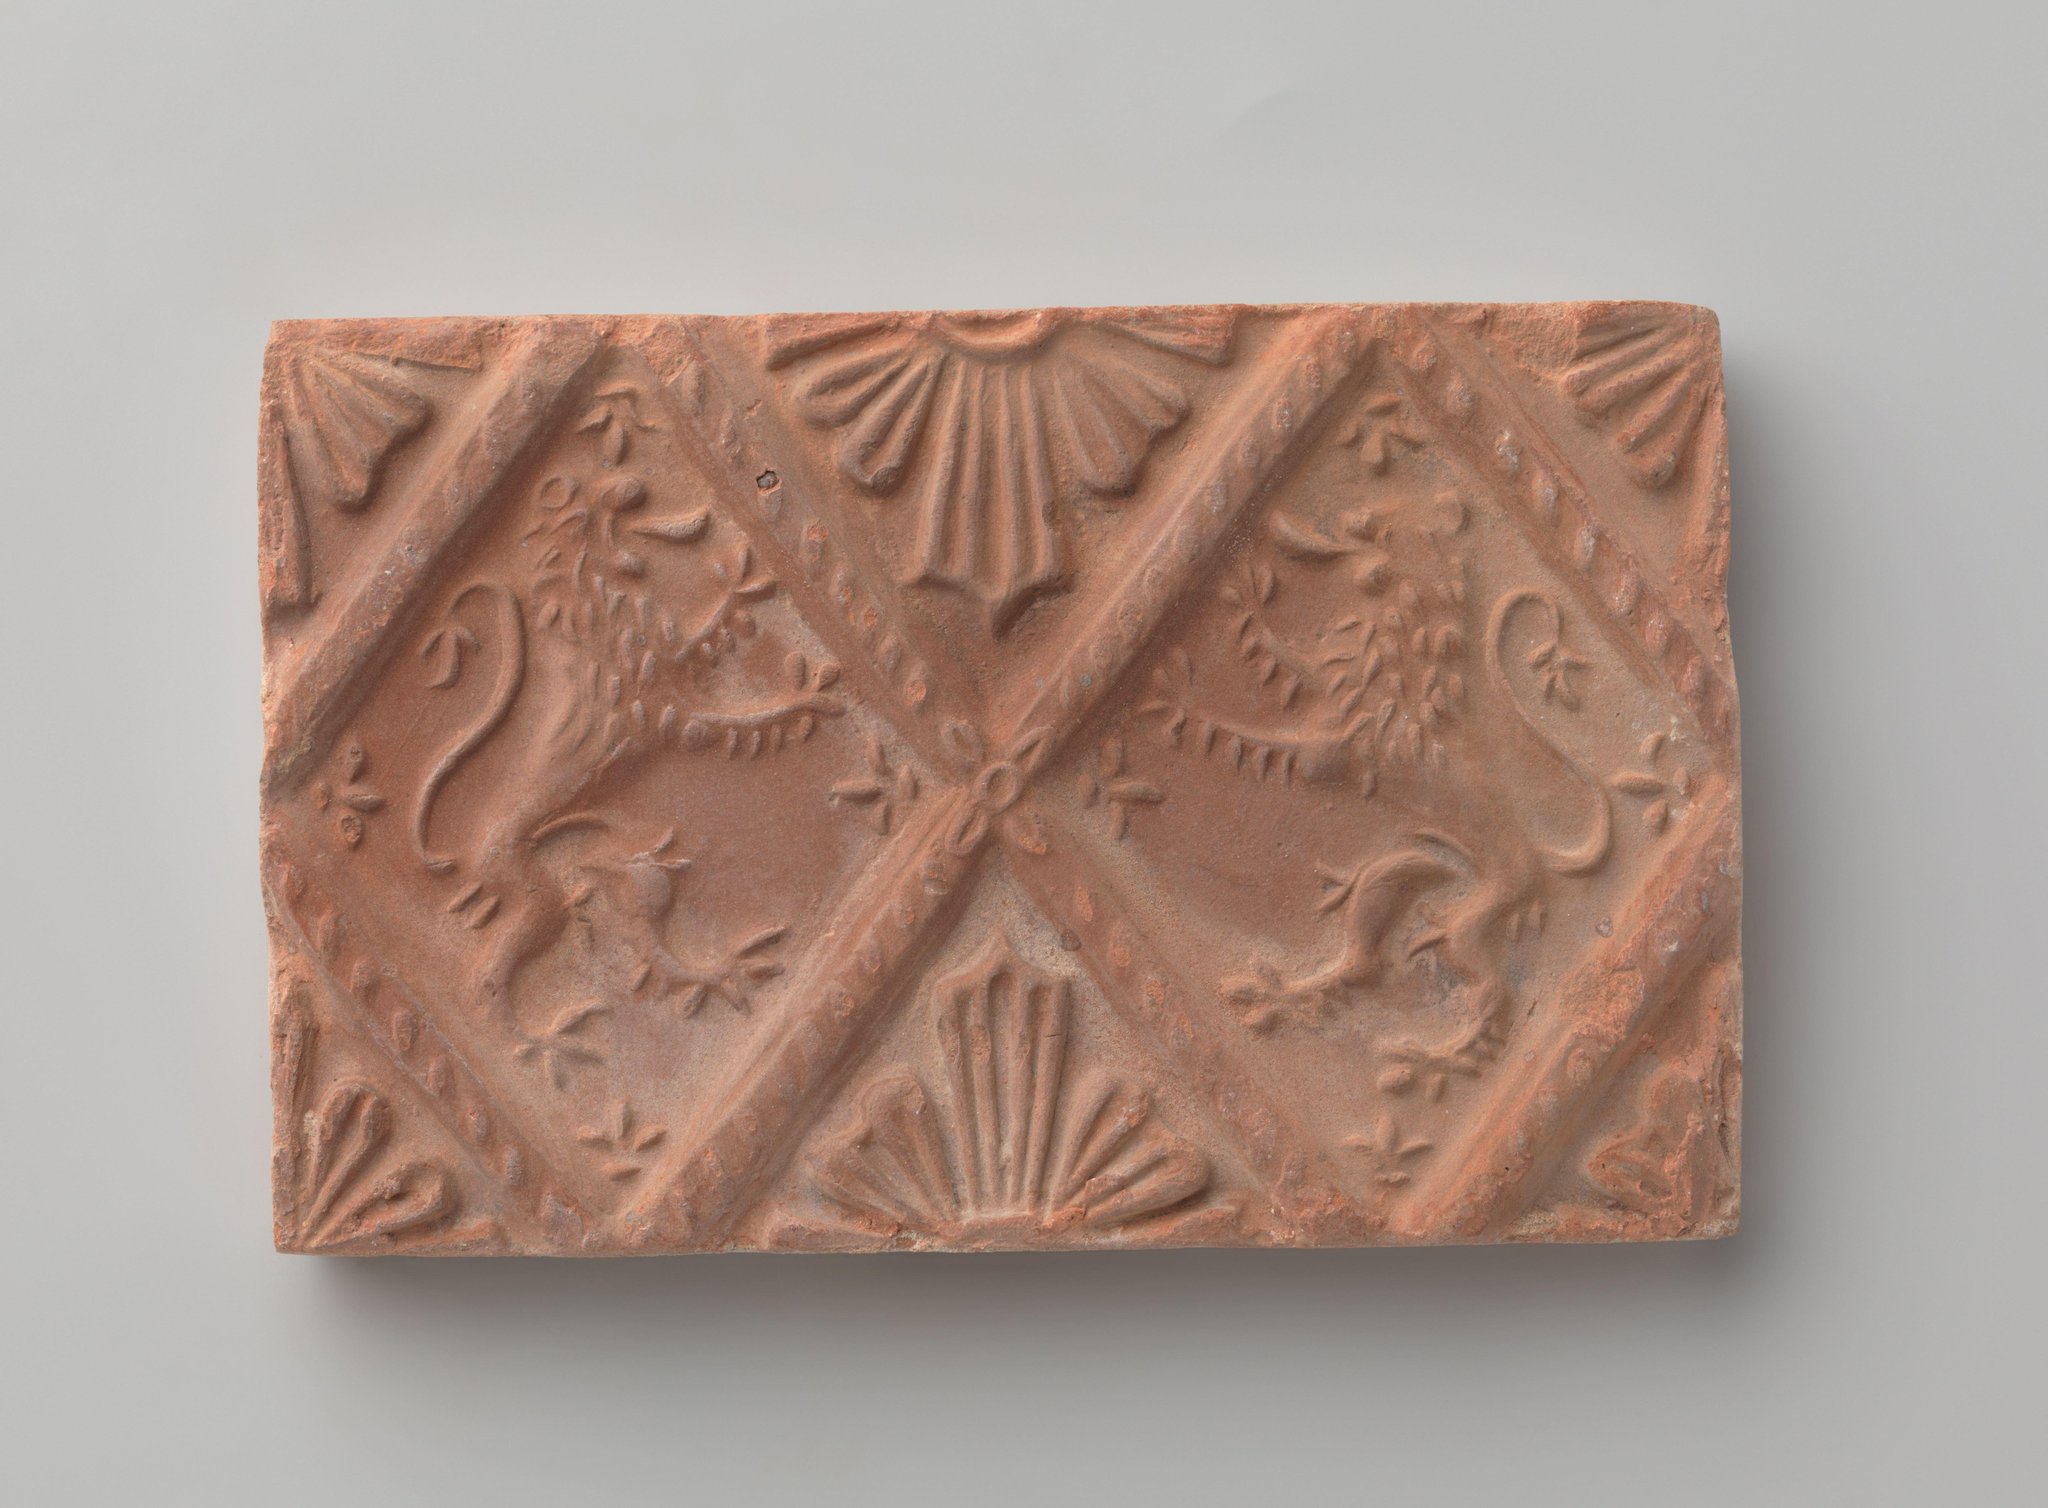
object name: hearthstone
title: Haardsteen met voorstelling van twee klimmende leeuwen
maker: Anonymous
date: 1875-1900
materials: earthenware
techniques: printing, firing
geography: netherlands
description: Haardsteen met voorstelling van twee klimmende leeuwen, geplaatst in geprofileerde ruit. De halve ruiten aan de boven- en onderkant zijn opgevuld met stermotief.